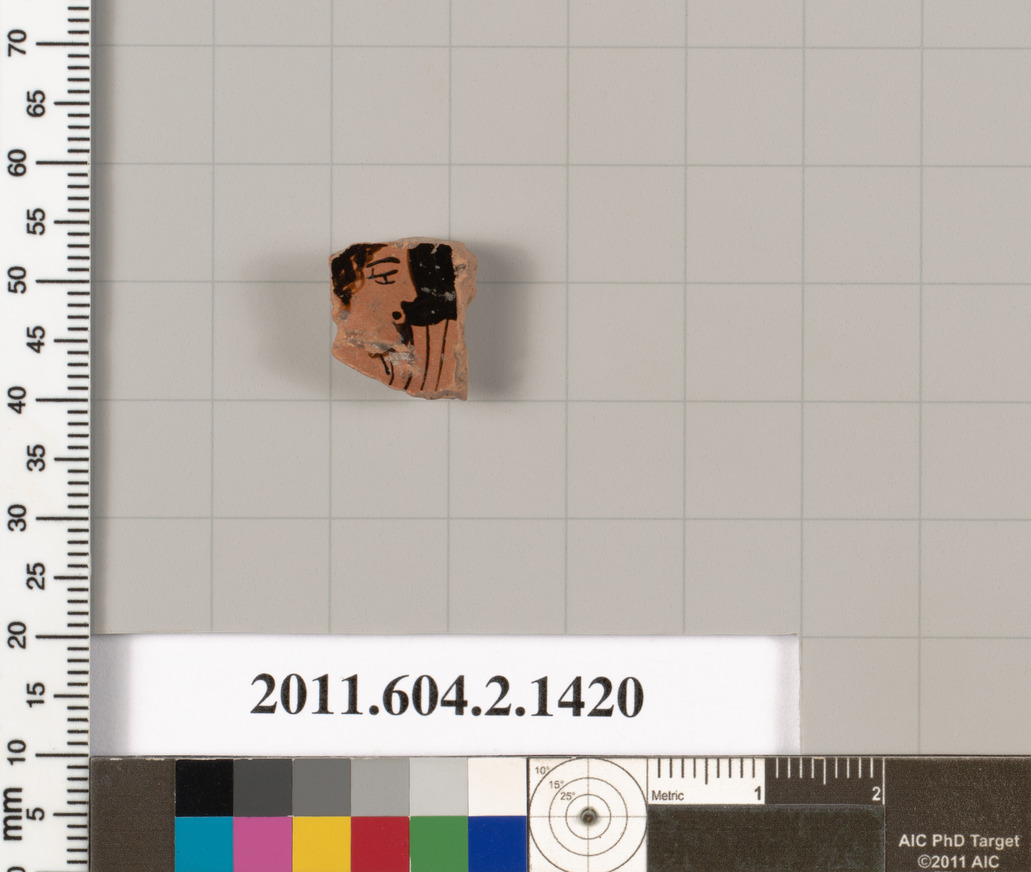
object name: skyphos fragment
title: Terracotta fragment of a skyphos (deep drinking cup)?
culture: greek, attic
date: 475-451 BCE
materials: terracotta